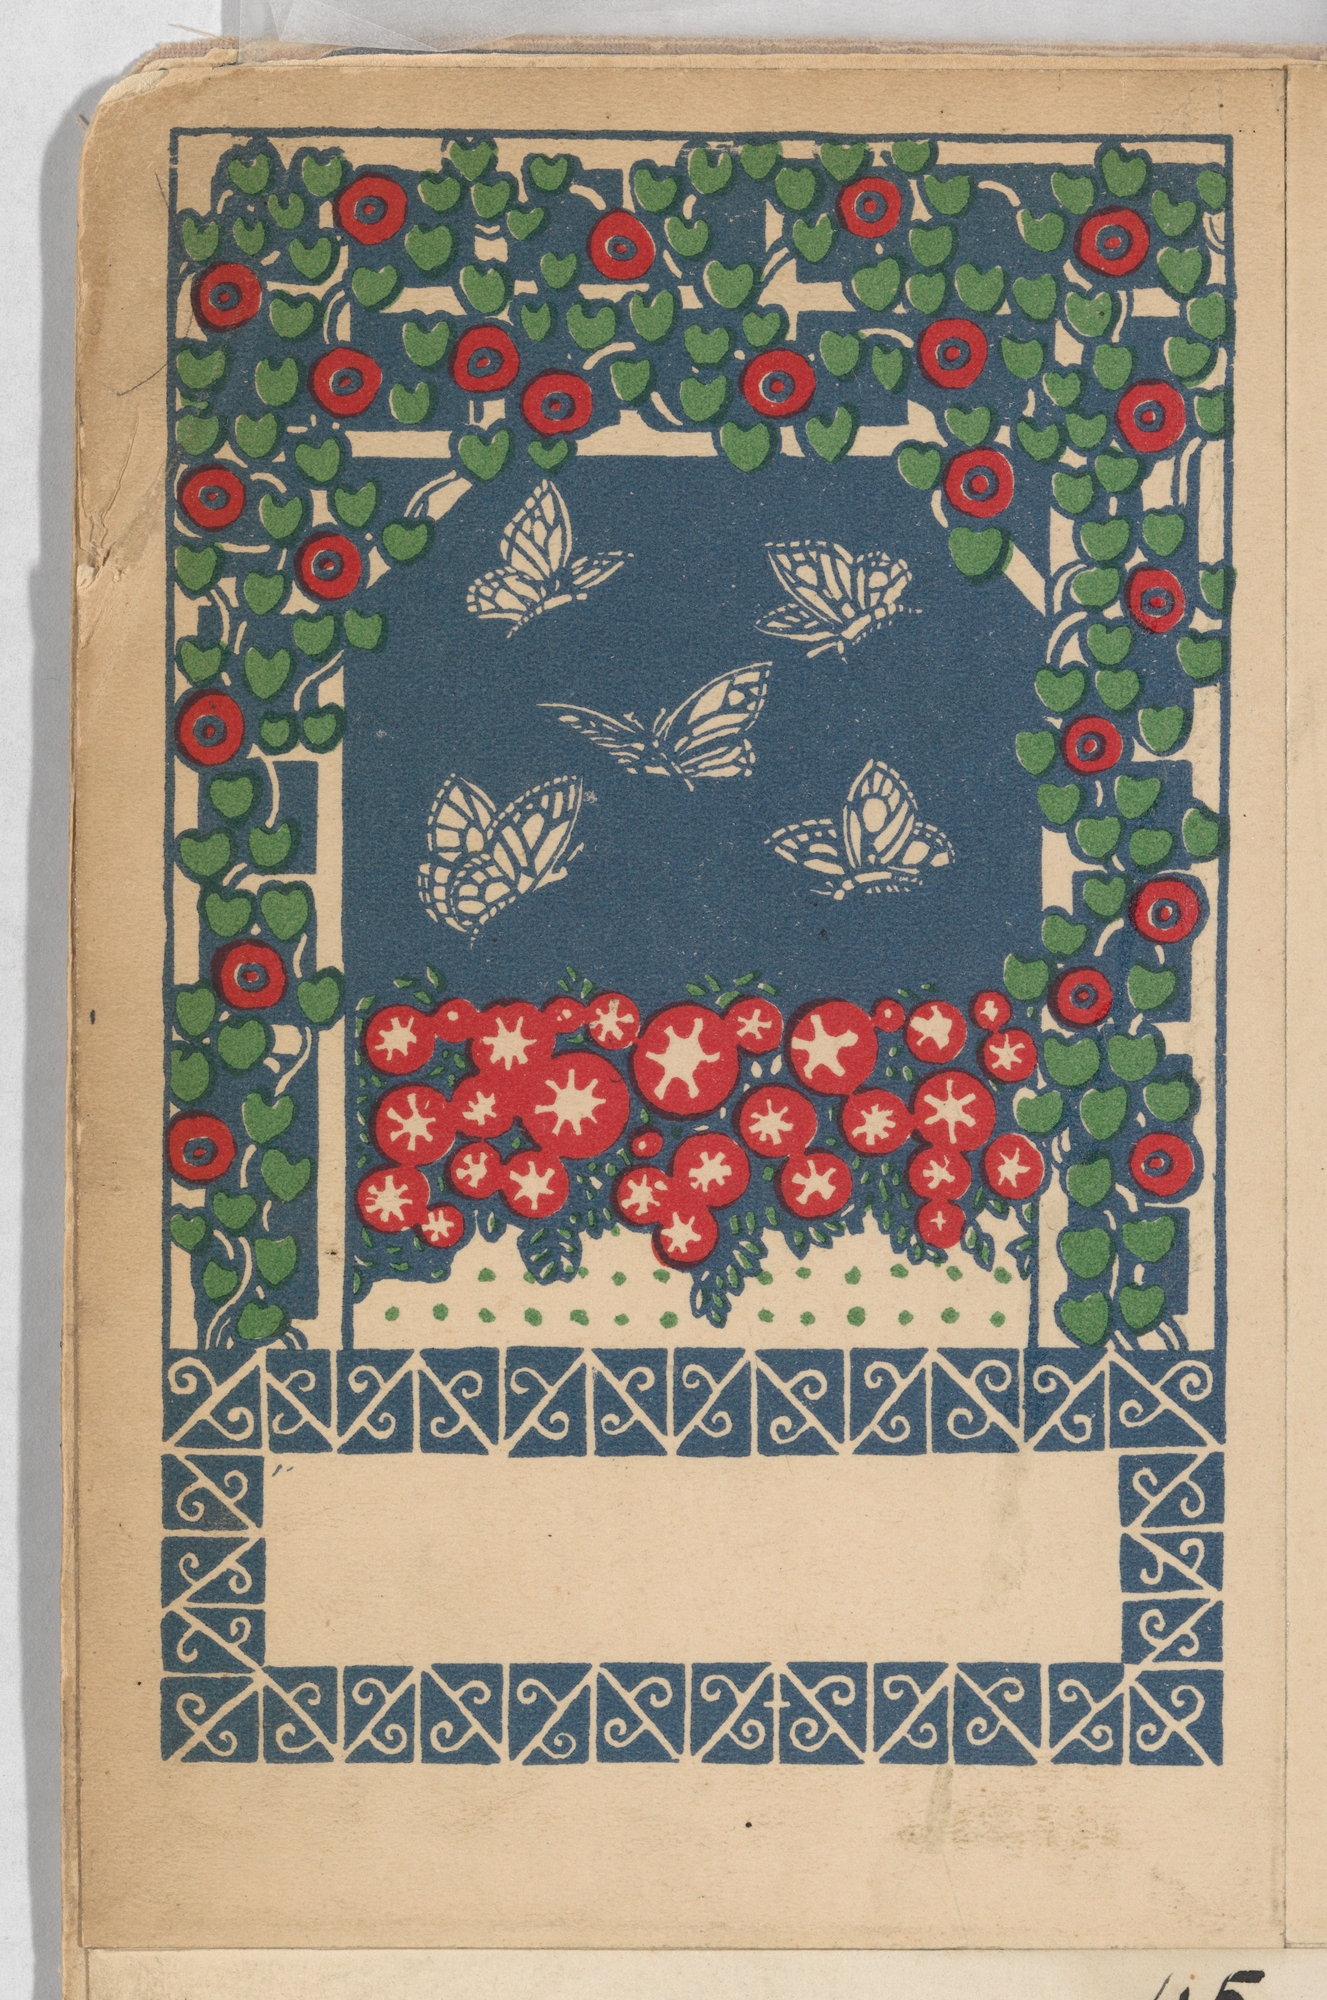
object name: print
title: Butterflies (Schmatterlingen)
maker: gustav kalhammer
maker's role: artist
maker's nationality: austrian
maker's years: 1886-1919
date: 1907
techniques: lithograph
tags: butterflies